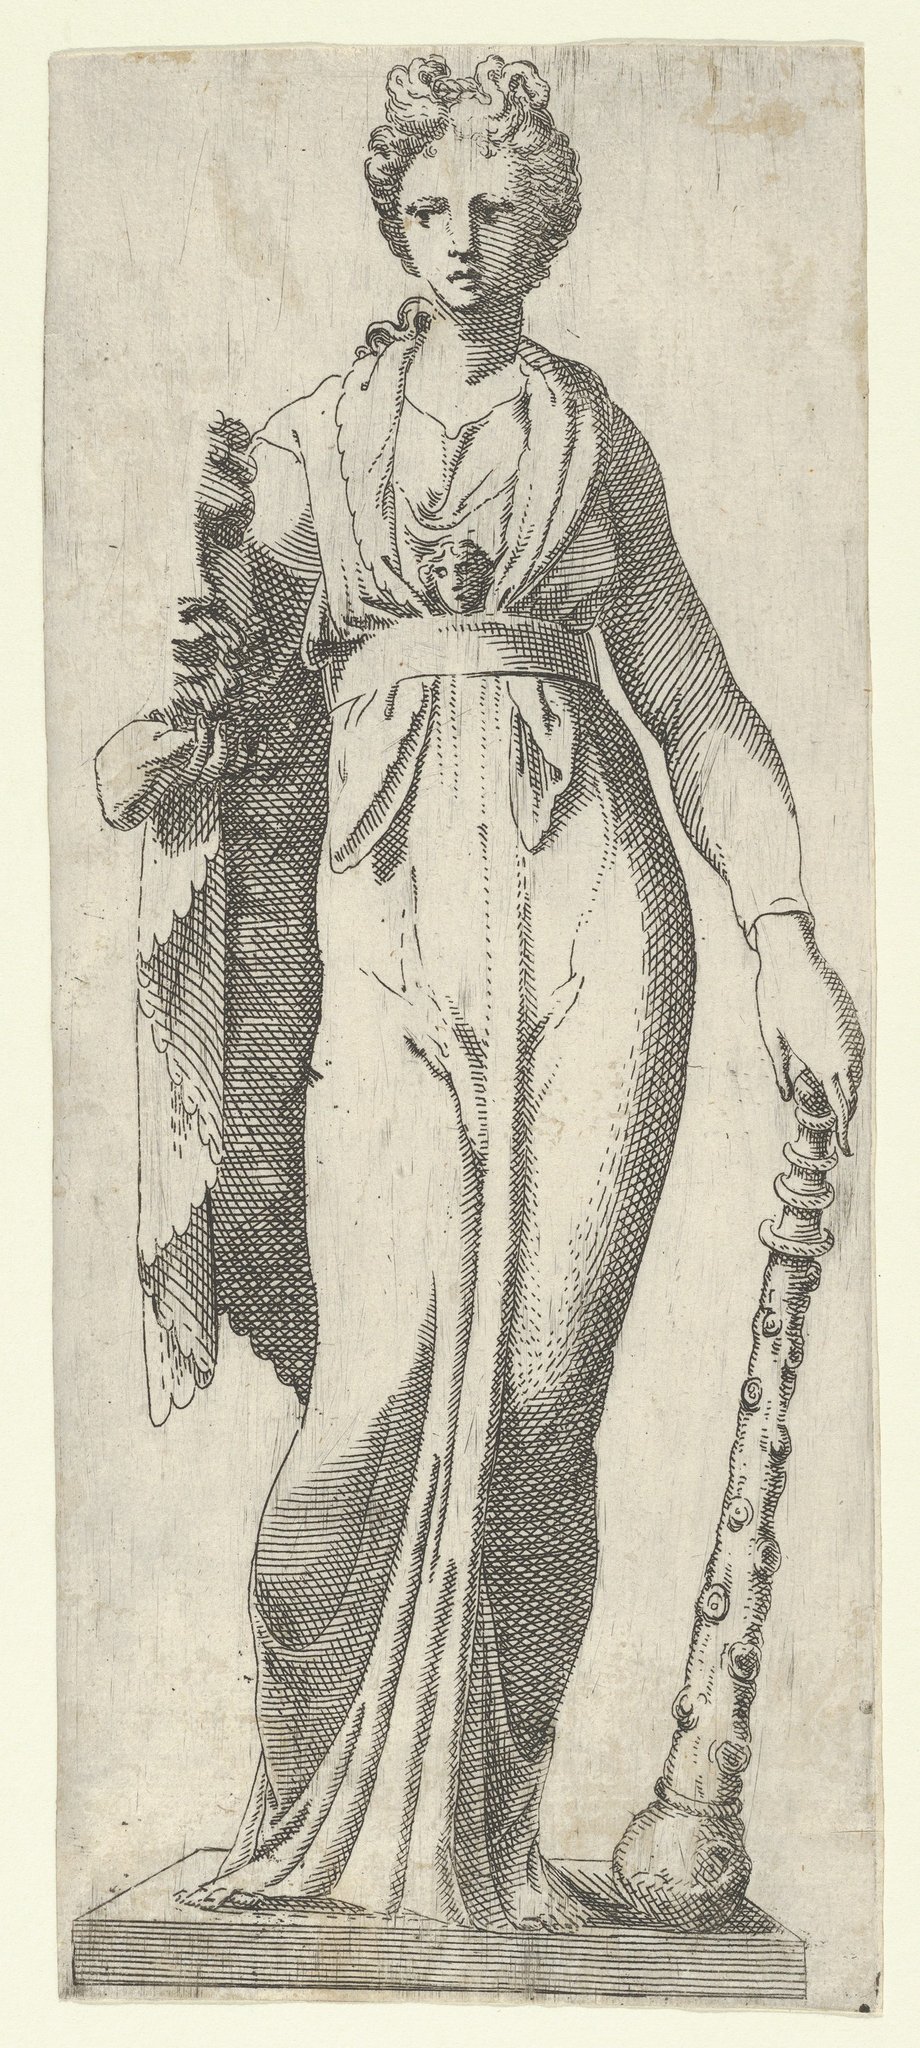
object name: print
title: Melpomene, from the Mattei sarcophagus, Rome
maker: antonio fantuzzi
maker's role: artist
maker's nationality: italian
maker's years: 1537-1545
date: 1540-1545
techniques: etching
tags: weapons